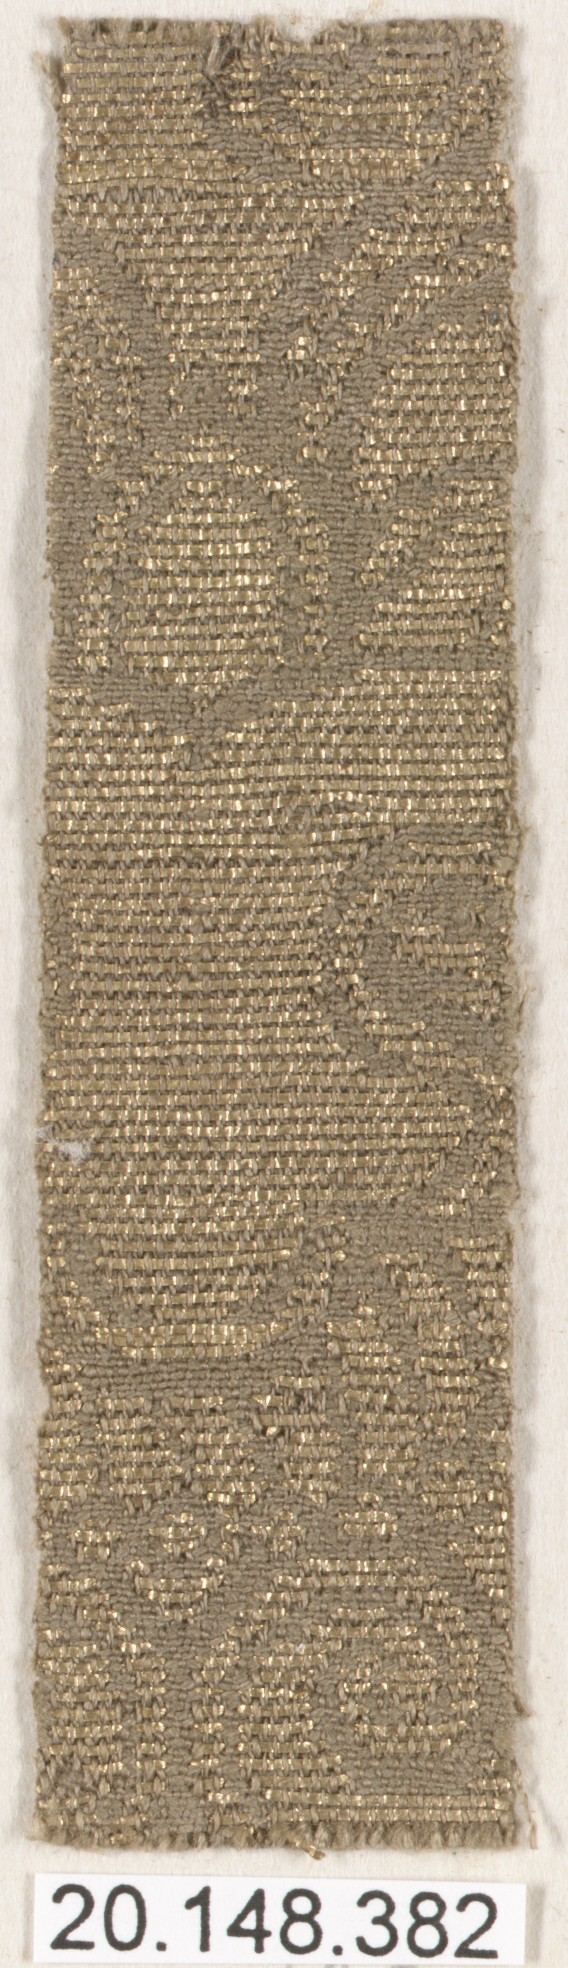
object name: piece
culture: japanese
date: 1701-1800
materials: silk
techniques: compound weave